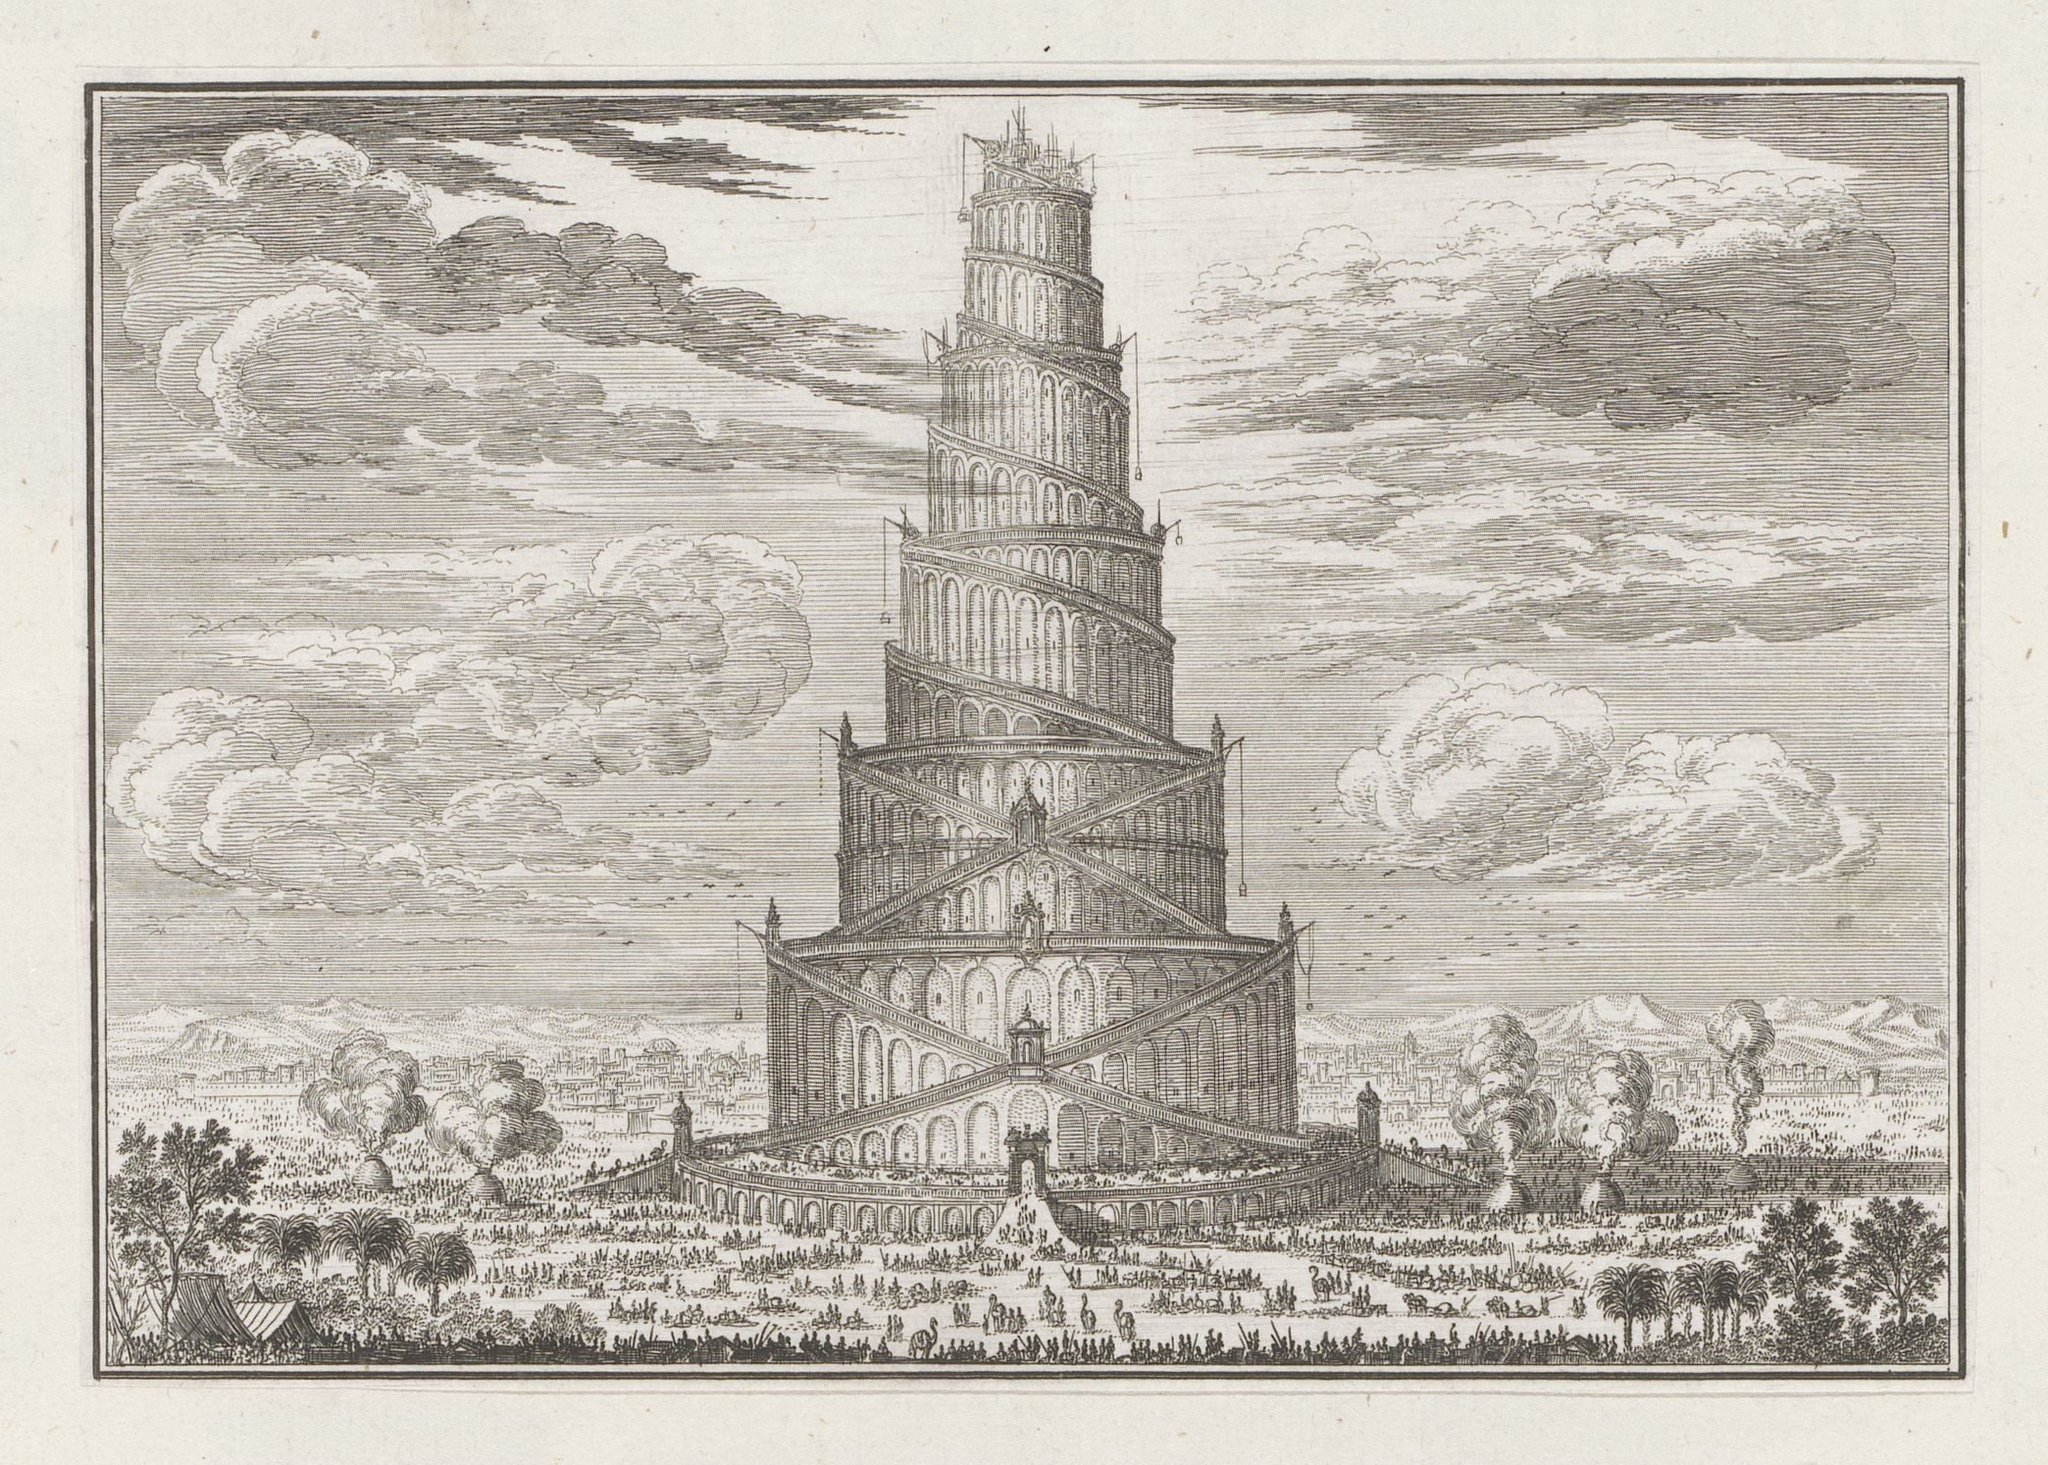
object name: album leaf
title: Toren van Babel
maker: Anonymous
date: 1600-1699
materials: paper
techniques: etching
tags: the building of the tower of babel; nimrod may be present, supervising or assisting the construction, the tower of babel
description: Landschap met de Toren van Babel in aanbouw. De prent maakt deel uit van een album.